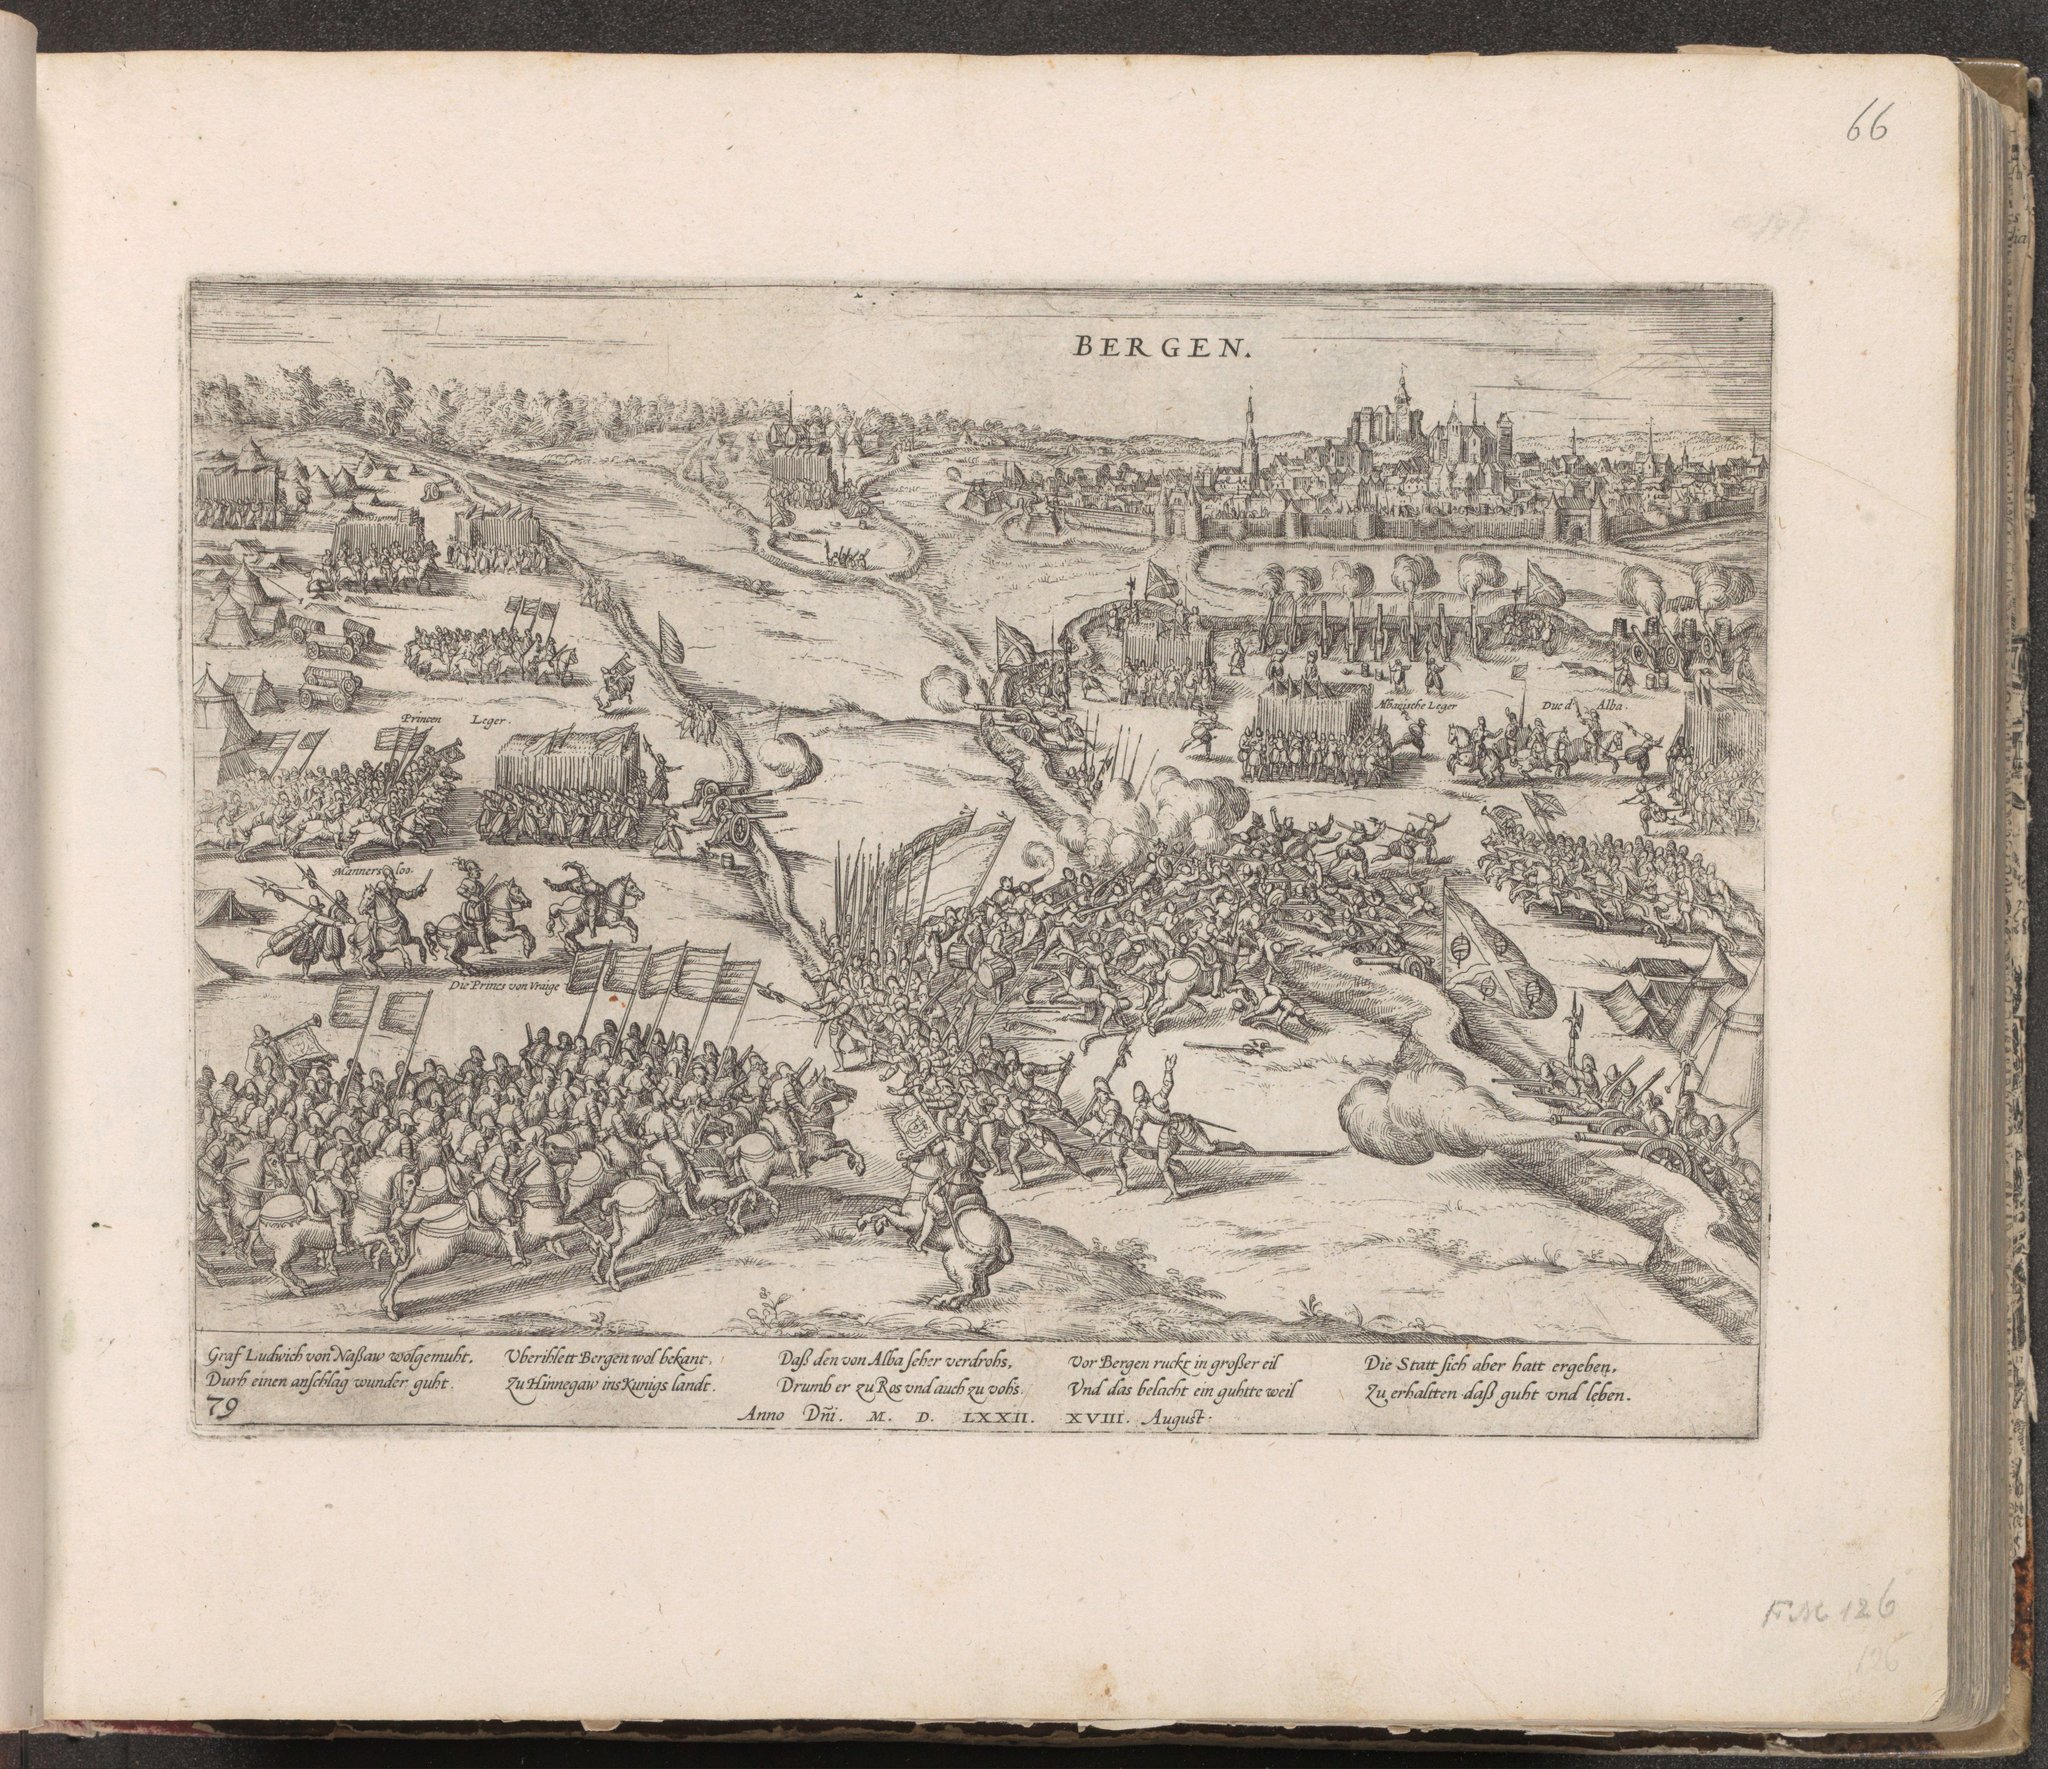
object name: album leaf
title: Bergen belegerd door Alva, 1572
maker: frans hogenberg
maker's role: print maker, publisher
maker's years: 1538-1590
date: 1574-1578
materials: paper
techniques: etching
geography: cologne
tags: delft, william i (prince of orange), fernando álvarez de toledo (3rd duke of alba), siege, position war, battle, fighting in general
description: Bergen (Mons) in Henegouwen belegerd door het leger van Alva, 18 augustus 1572. De stad bezet door de troepen van Lodewijk van Nassau. Van links komt het leger van Willem van Oranje in een poging om de stad te ontzetten. Met onderschrift van 8 regels in het Duits. Linksonder genummerd: 79. De prent maakt deel uit van een album.